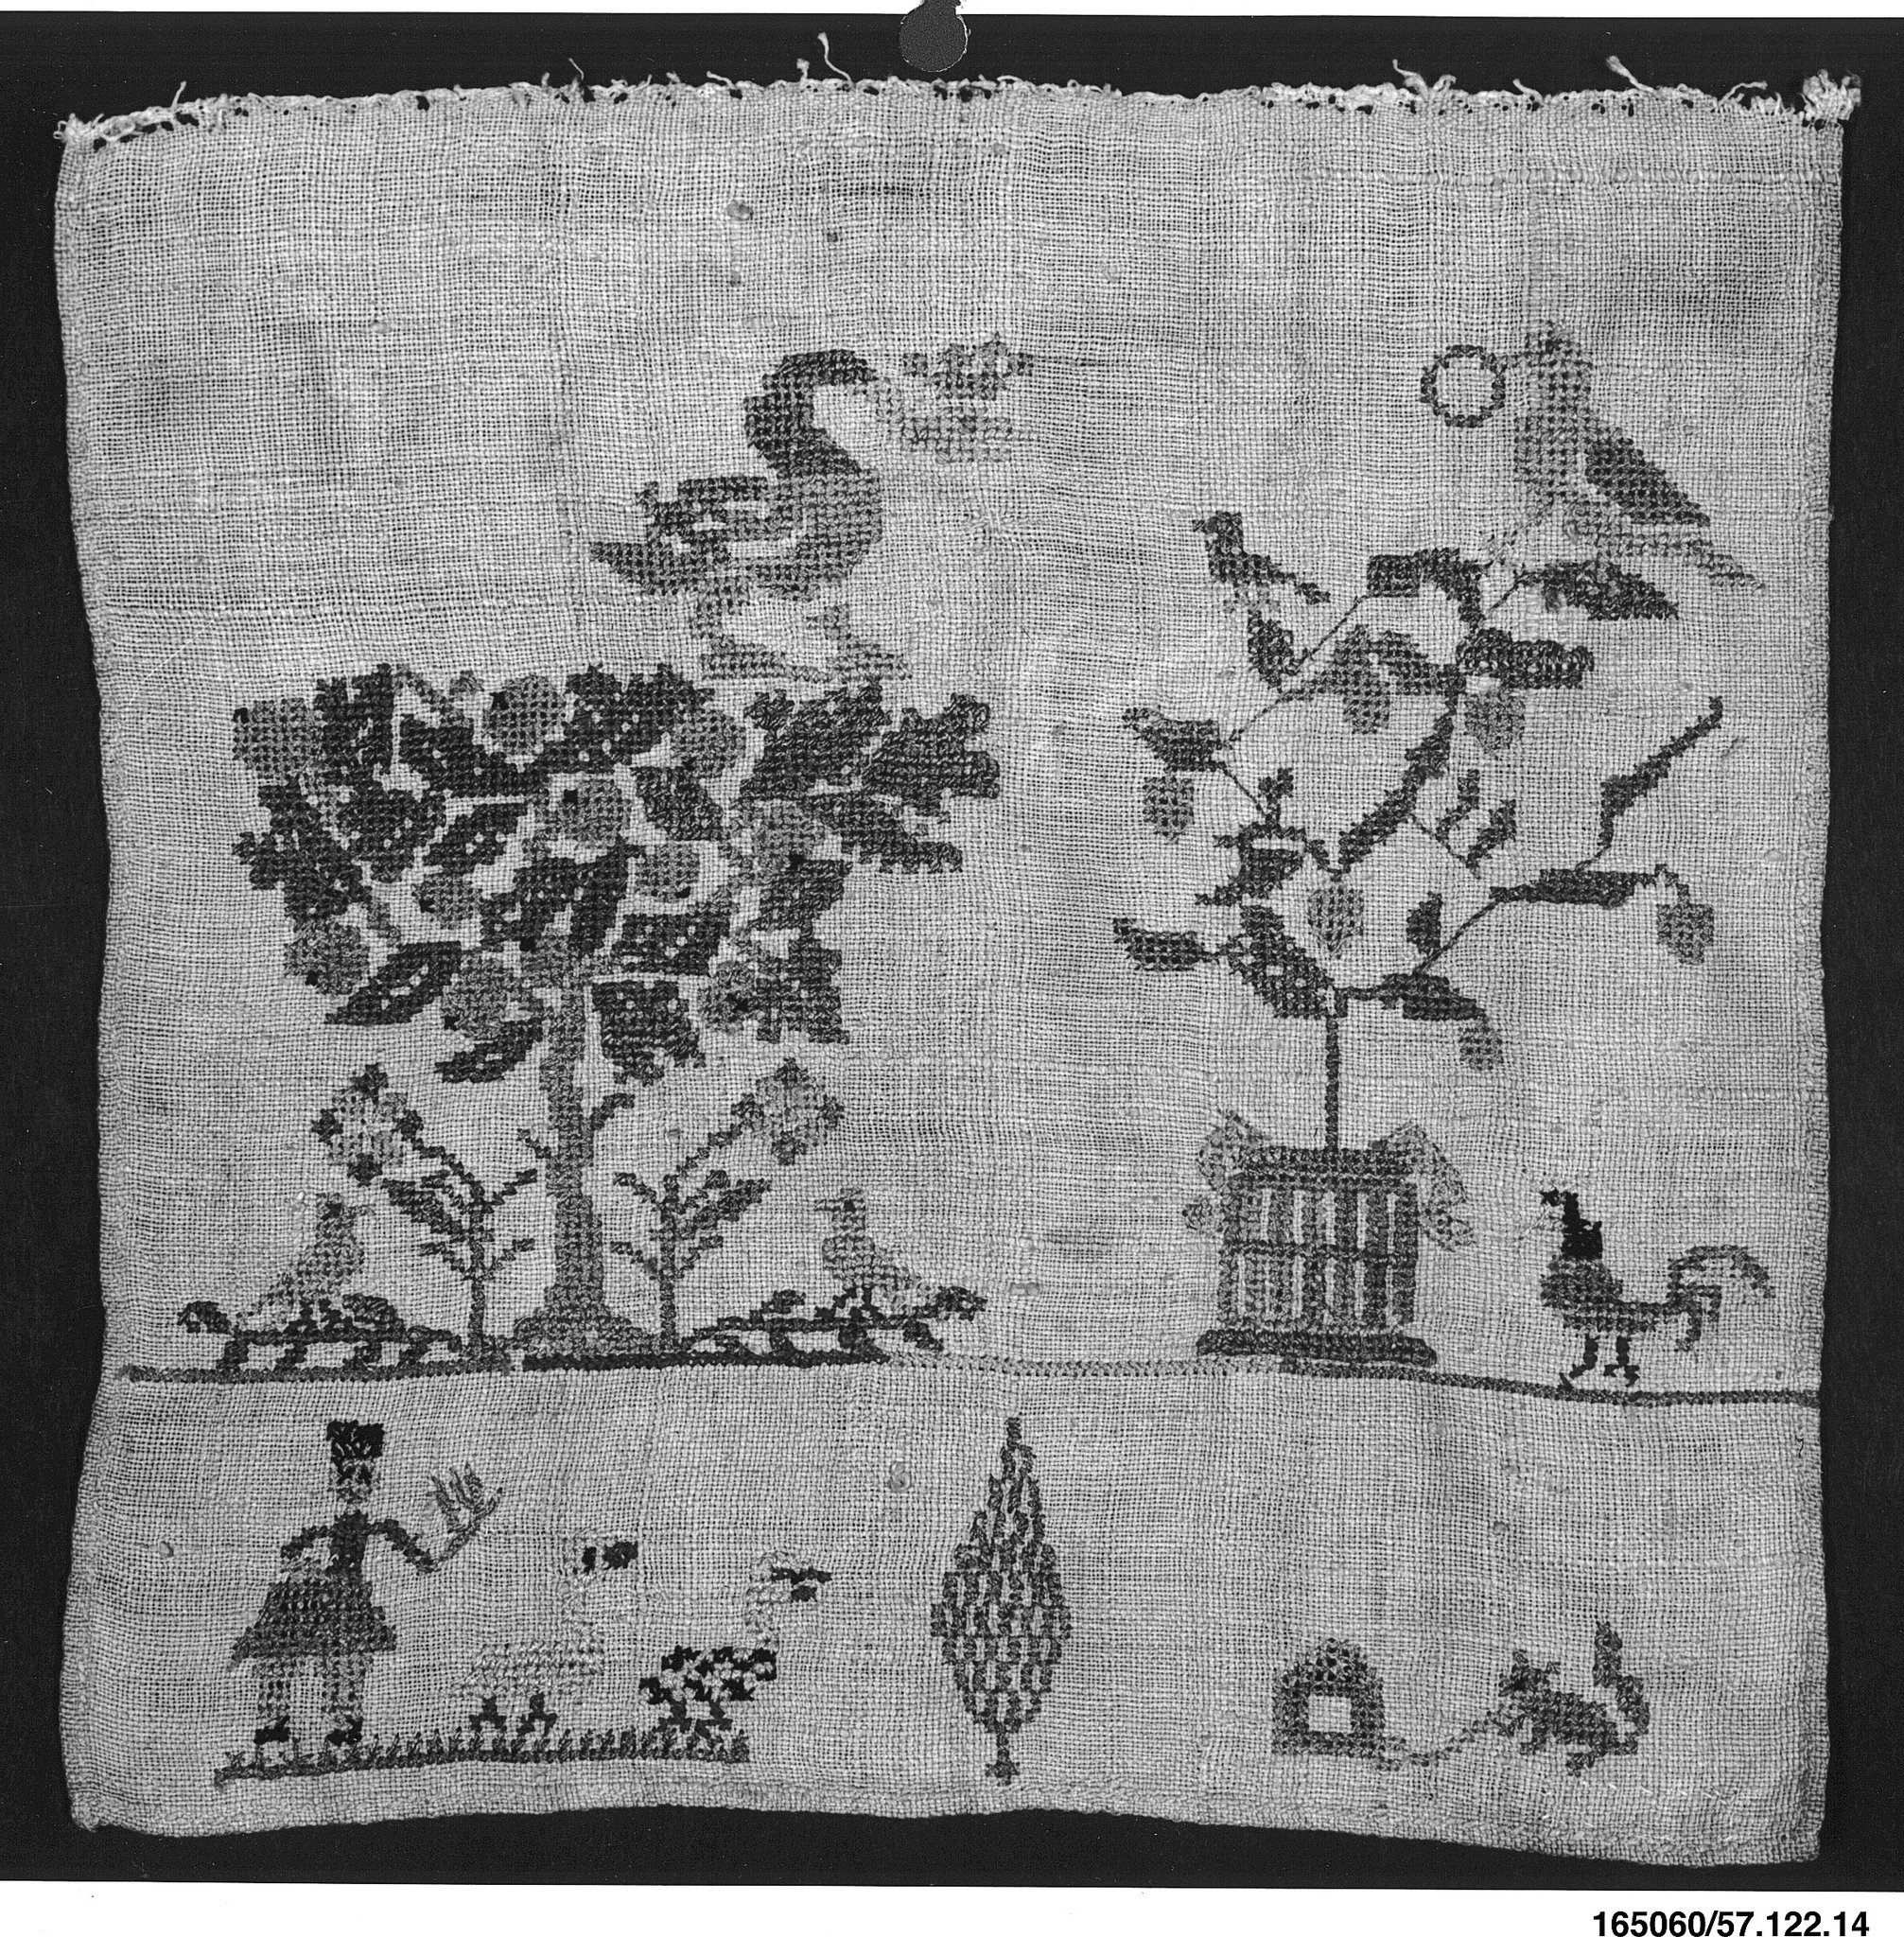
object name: sampler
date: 1701-1800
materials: linen, silk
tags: human figures,birds,trees